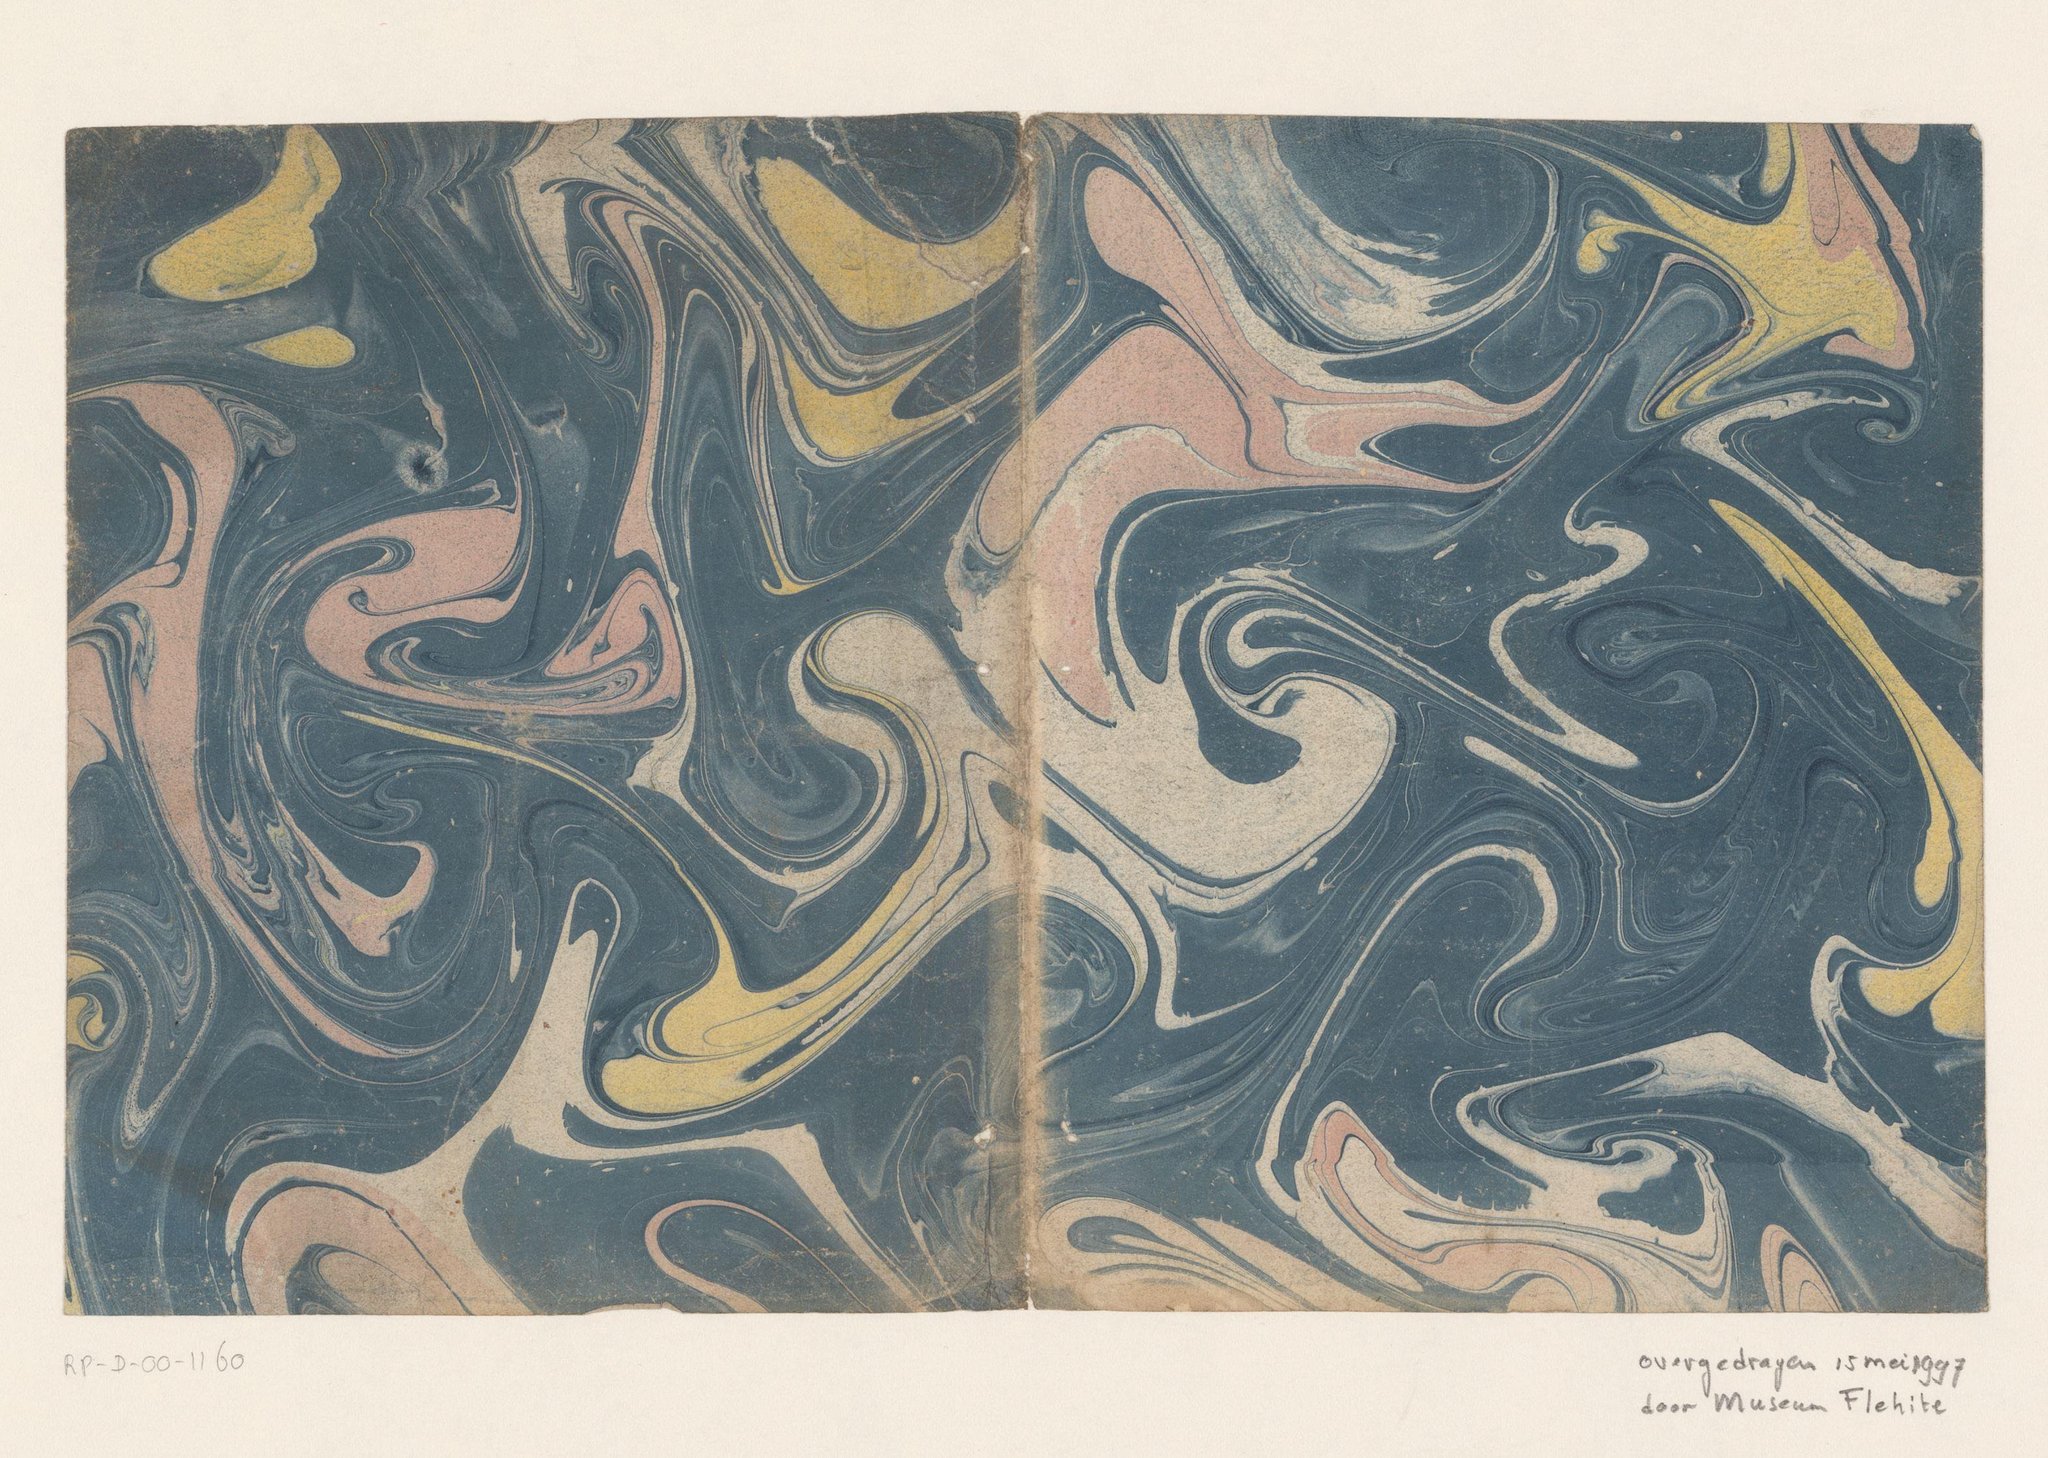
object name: marbled paper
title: Fantasie- of lussenmarmer in blauw, roze en geel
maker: Anonymous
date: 1700-1850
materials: paint, paper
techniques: marbled paper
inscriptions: collector's mark: Lugt 2228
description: Fantasie- of lussenmarmer in blauw, roze en geel. Gebruikt als omslag.